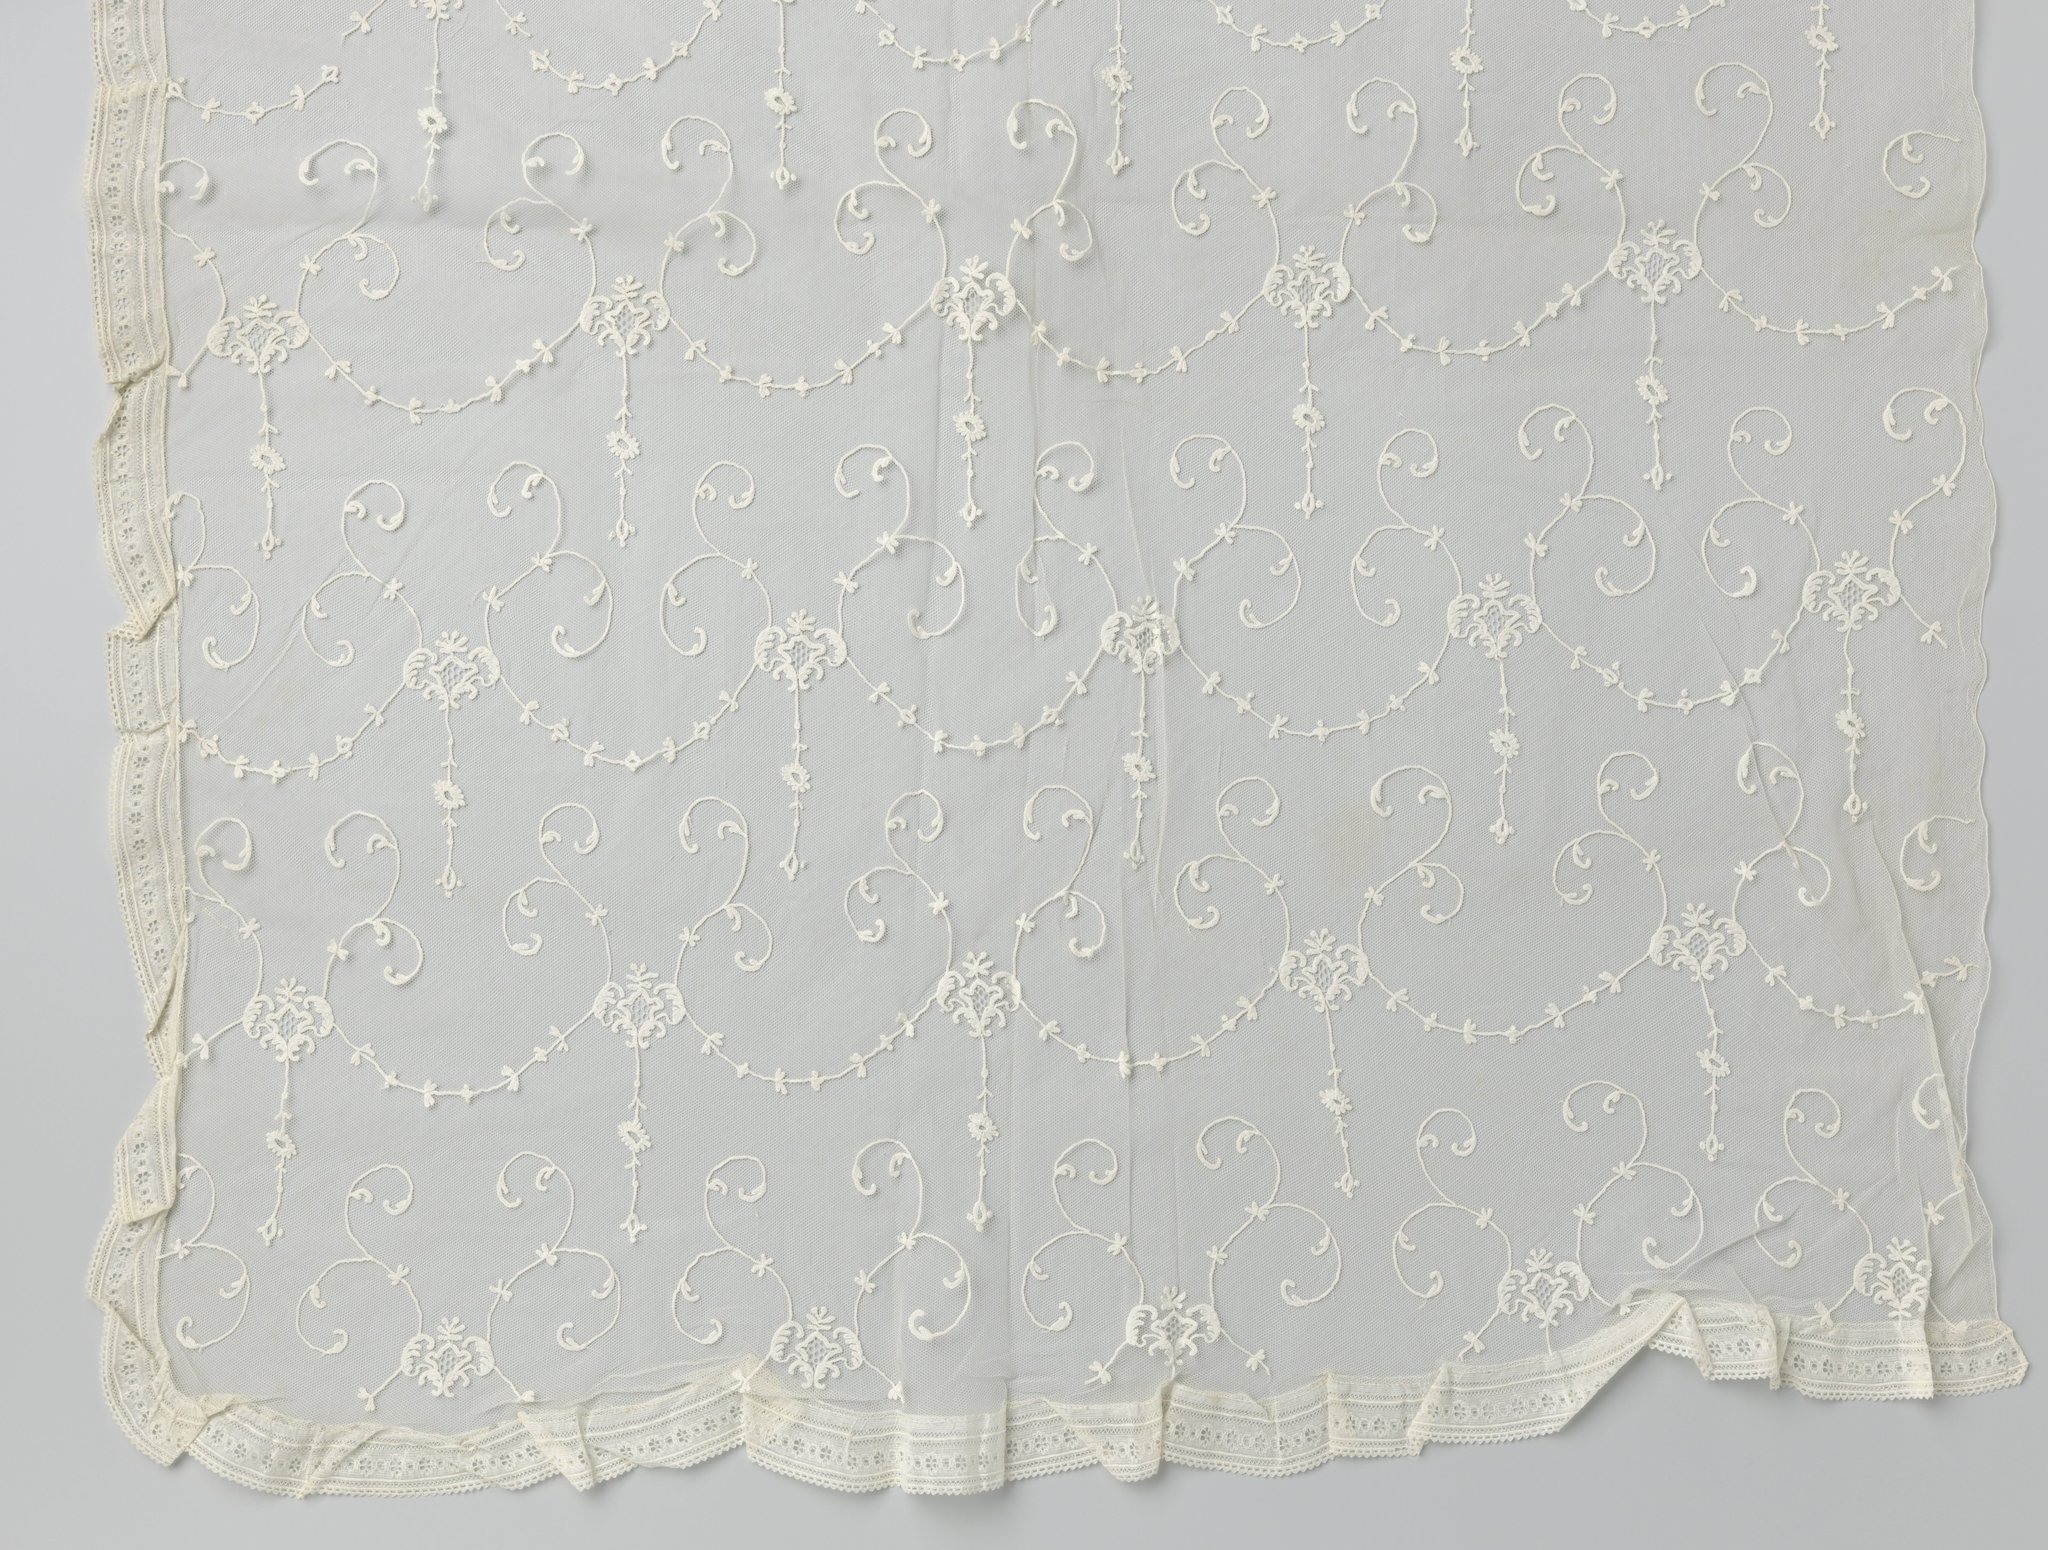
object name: curtain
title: Gordijn van tule met ranken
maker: Anonymous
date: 1700-1899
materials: fiber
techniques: embroidered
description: Tulen gordijn met geborduurde ranken voor een boudoir.